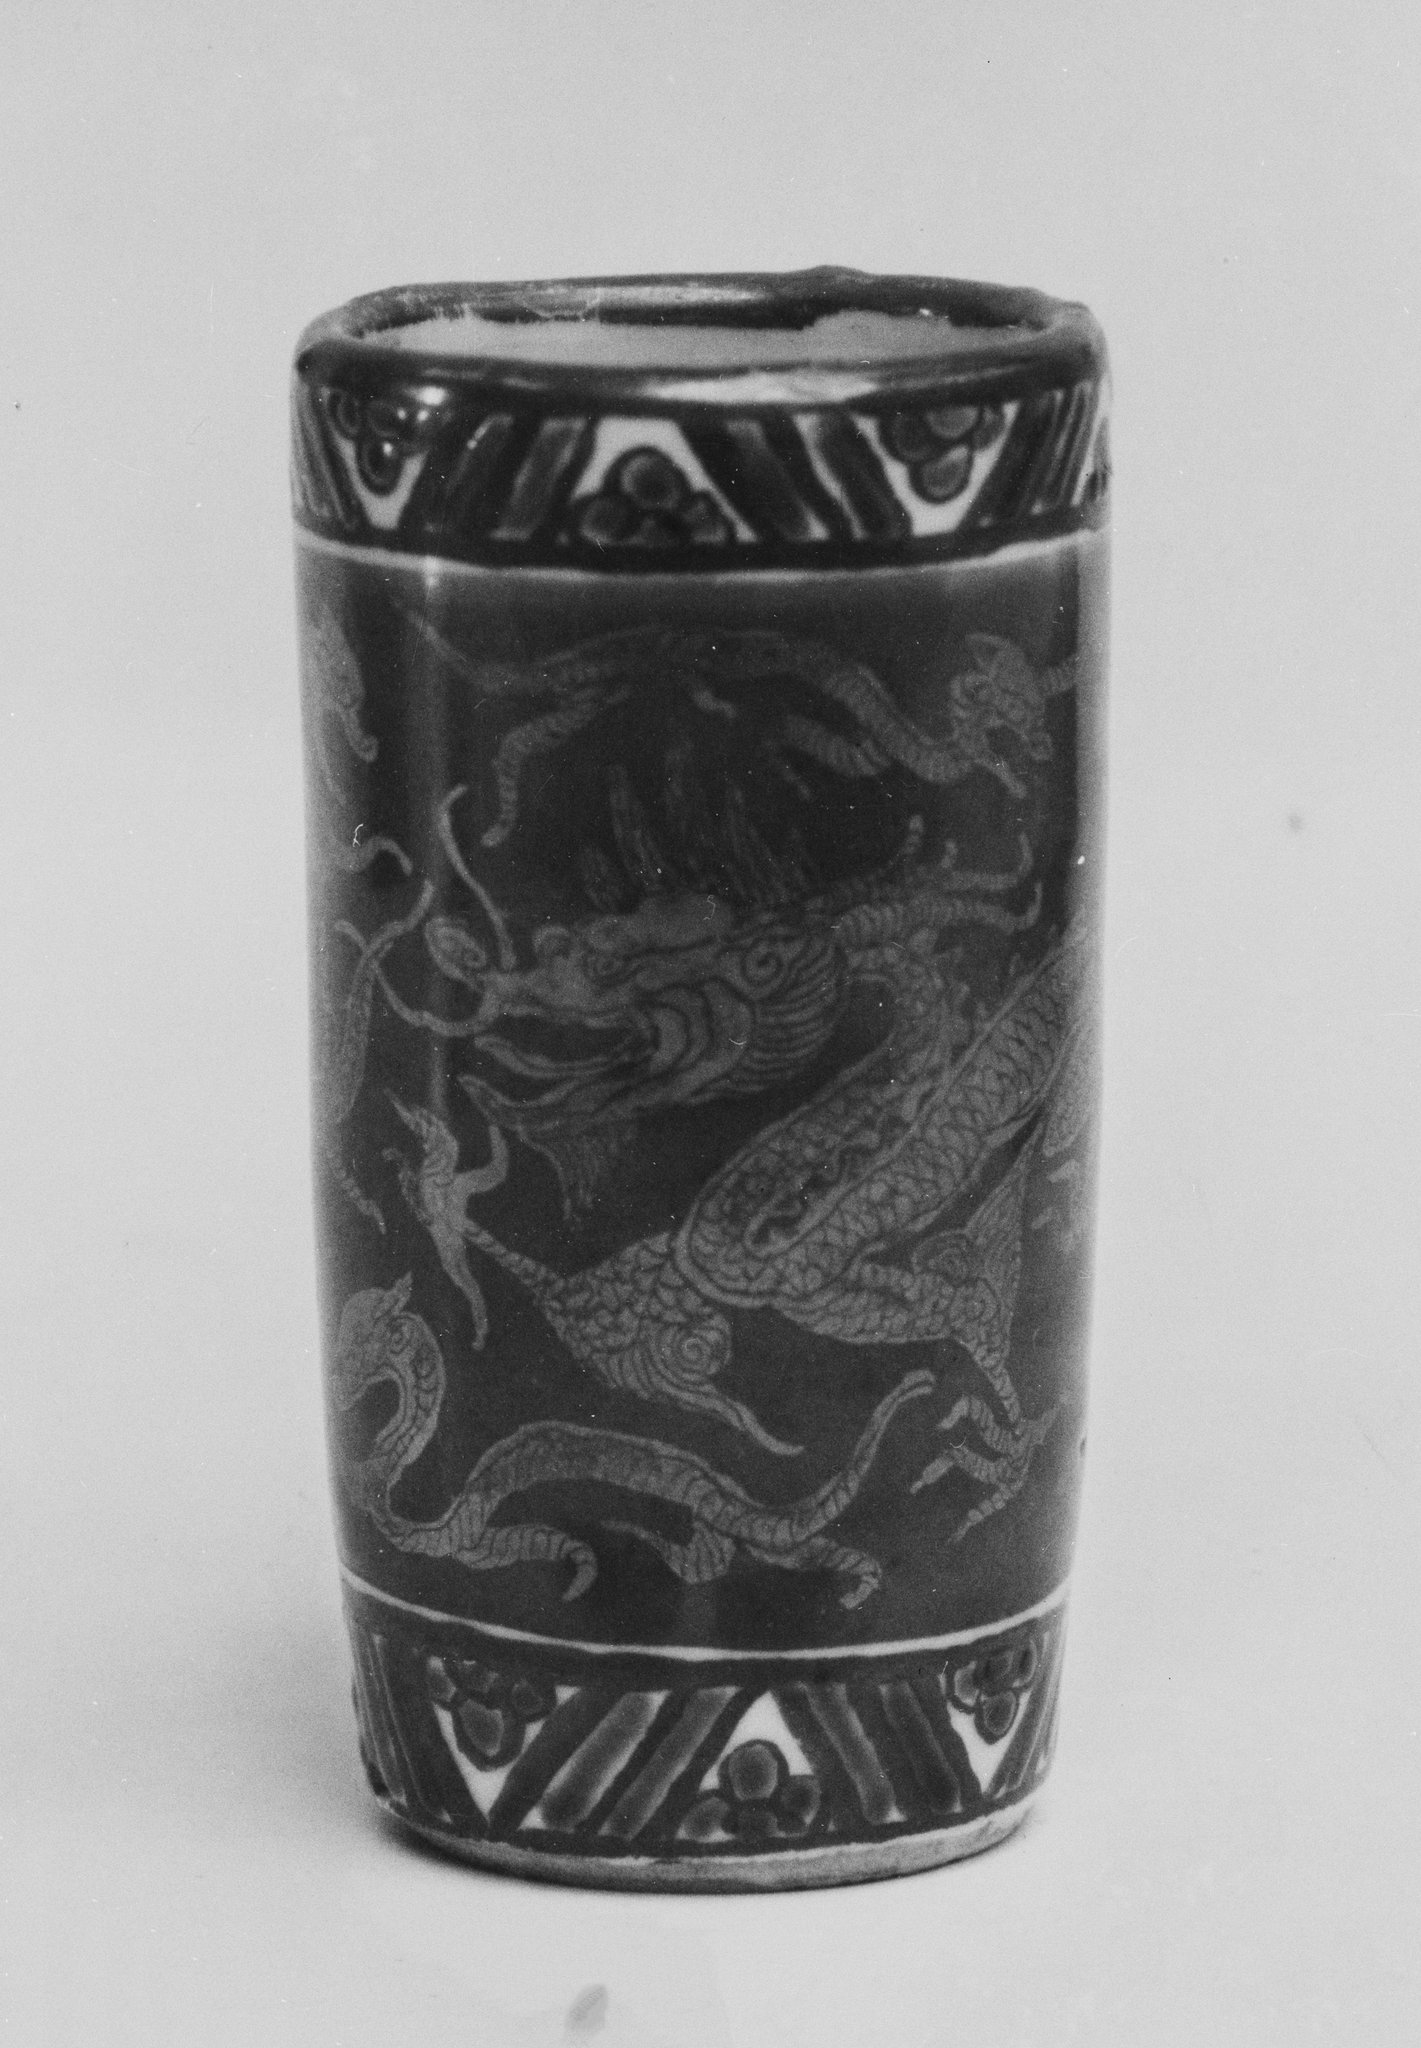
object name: tea cloth holder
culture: japanese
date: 1680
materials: enamel, gold, porcelain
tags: dragons